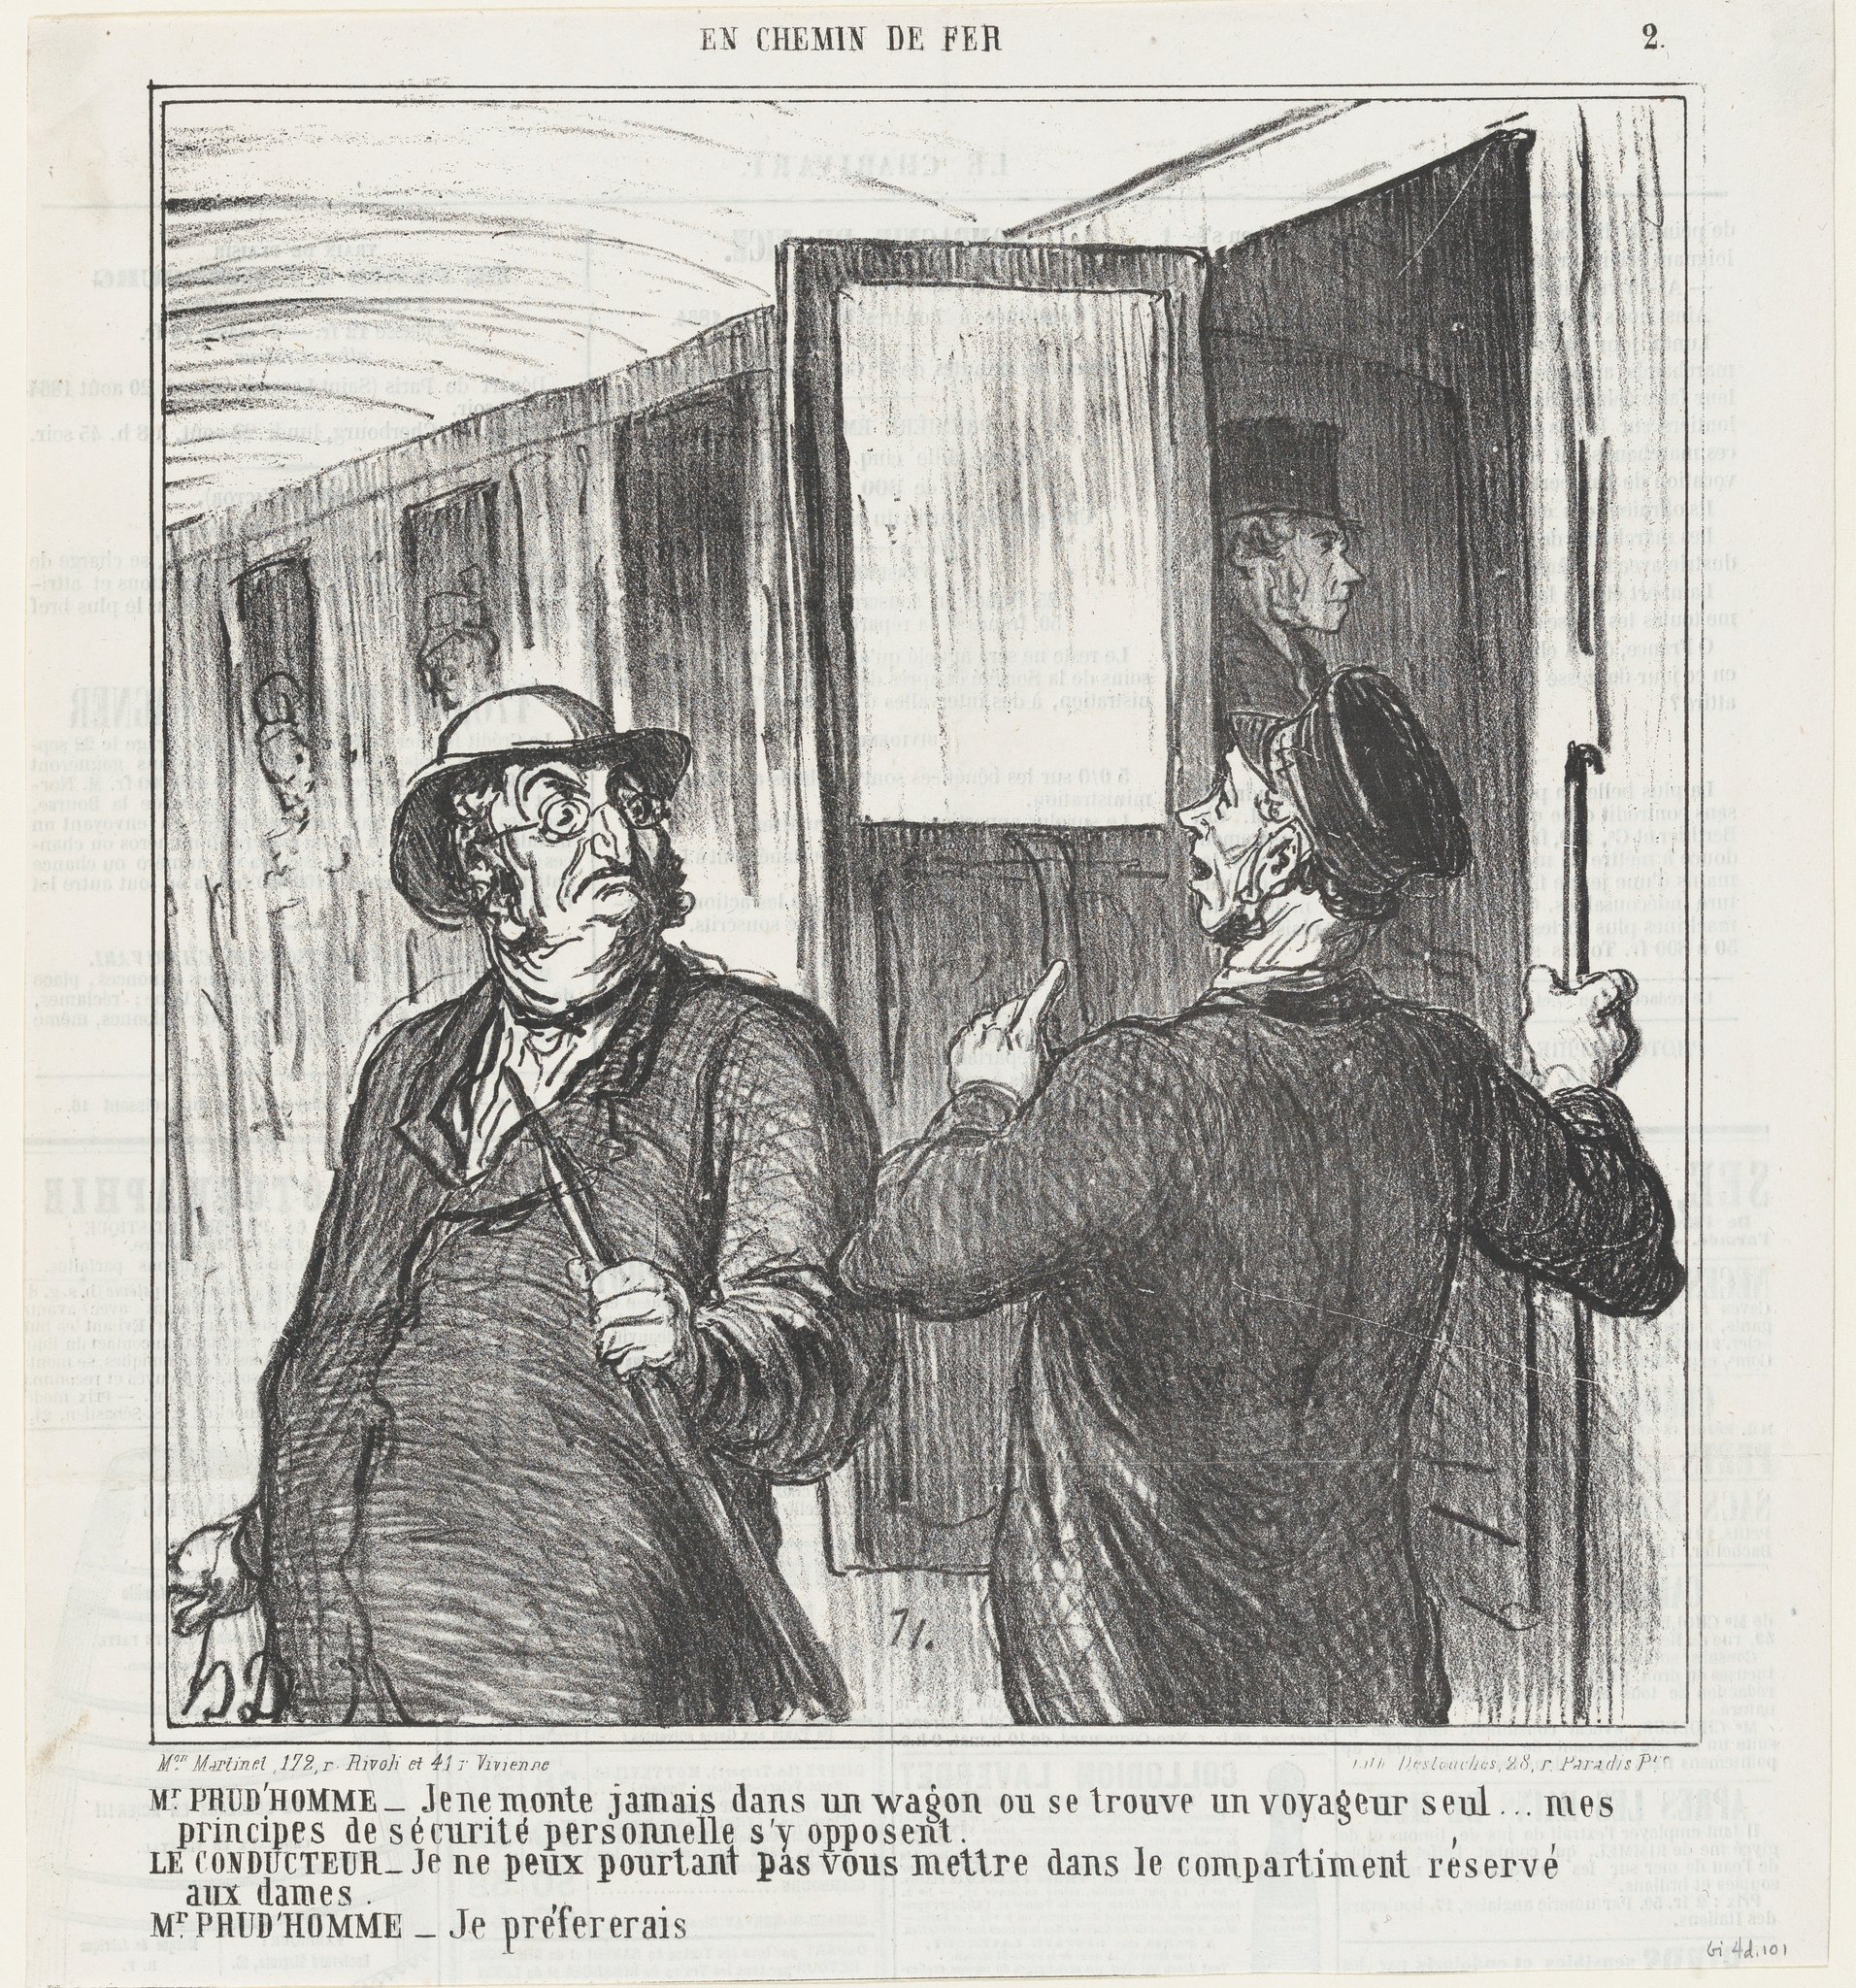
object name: print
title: Mr. Prudhomme: I shall never get into a compartment alone with a single traveler... principles of personal safety are contrary to that, from 'On the train,' published in Le Charivari, August 18, 1864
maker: honoré daumier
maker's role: artist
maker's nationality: french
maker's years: 1808-1879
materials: paper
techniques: lithograph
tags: men,trains